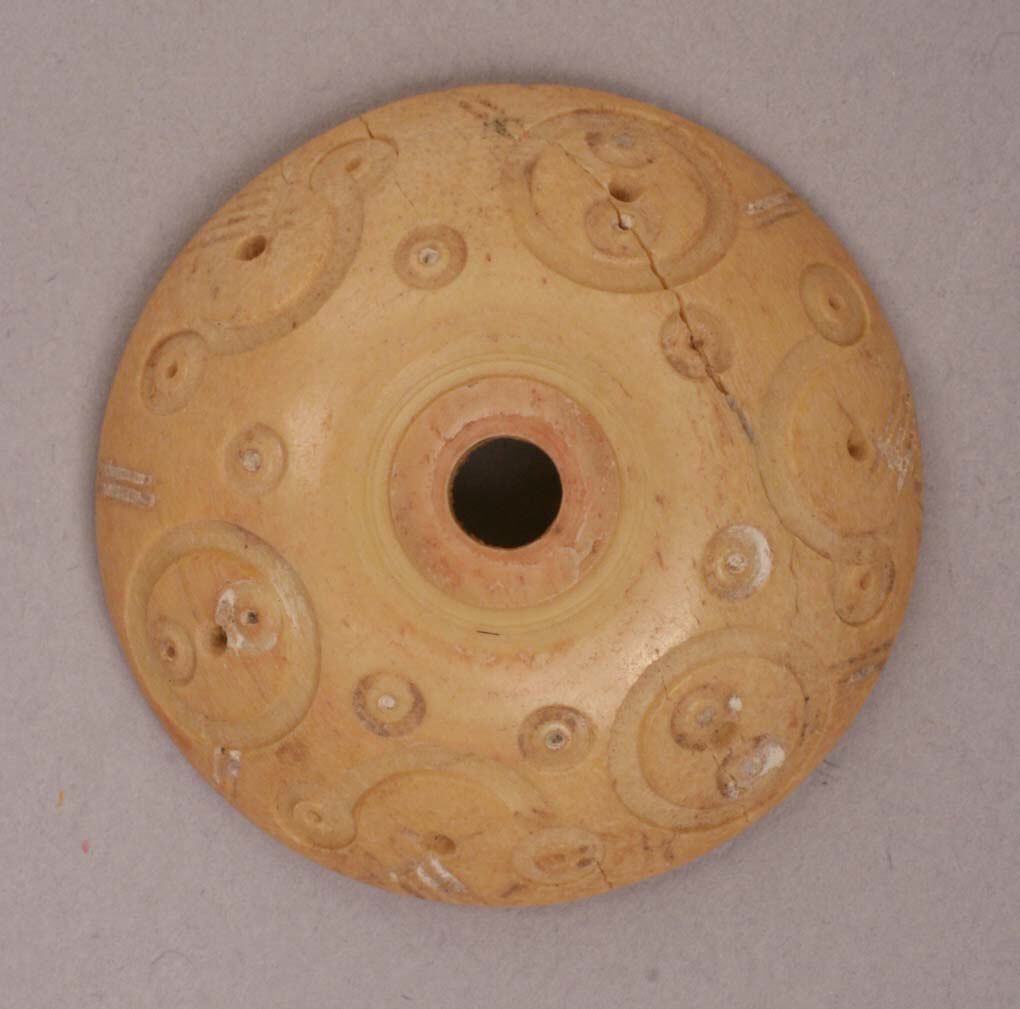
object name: button or spindle whorl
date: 801-1000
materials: bone, paint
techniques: incising, inlay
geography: iran